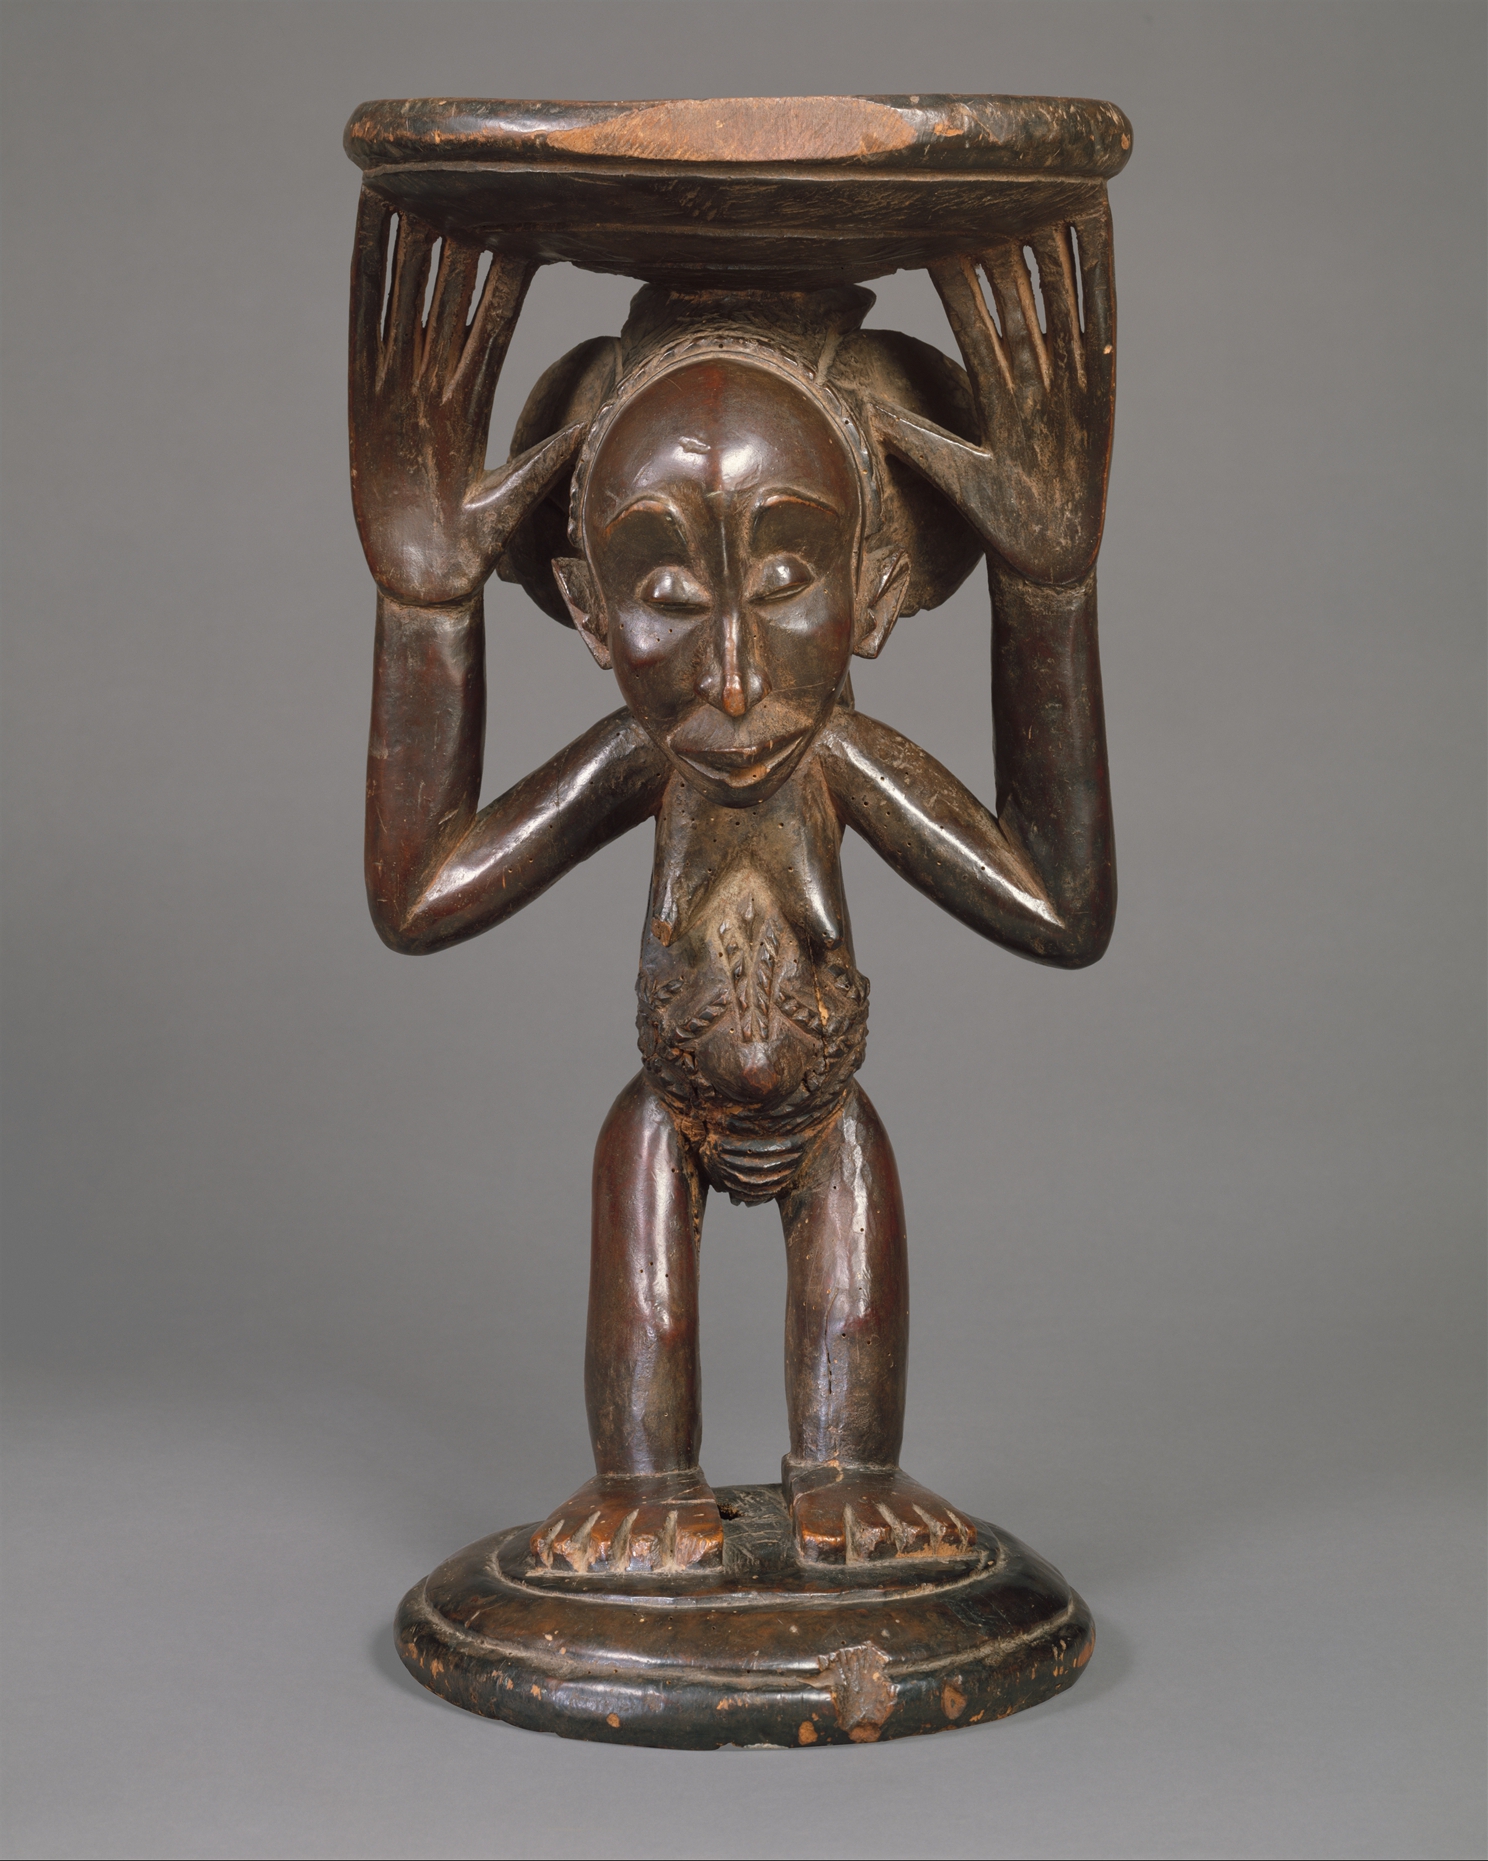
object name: stool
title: Lupona (royal seat)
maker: ngongo ya chintu, formerly known as the "buli master" (ca. 1810-1870, kateba region, democratic republic of the congo)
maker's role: artist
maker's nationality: democratic republic of congo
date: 1840-1870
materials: metal, wood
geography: democratic republic of the congo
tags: caryatids,women